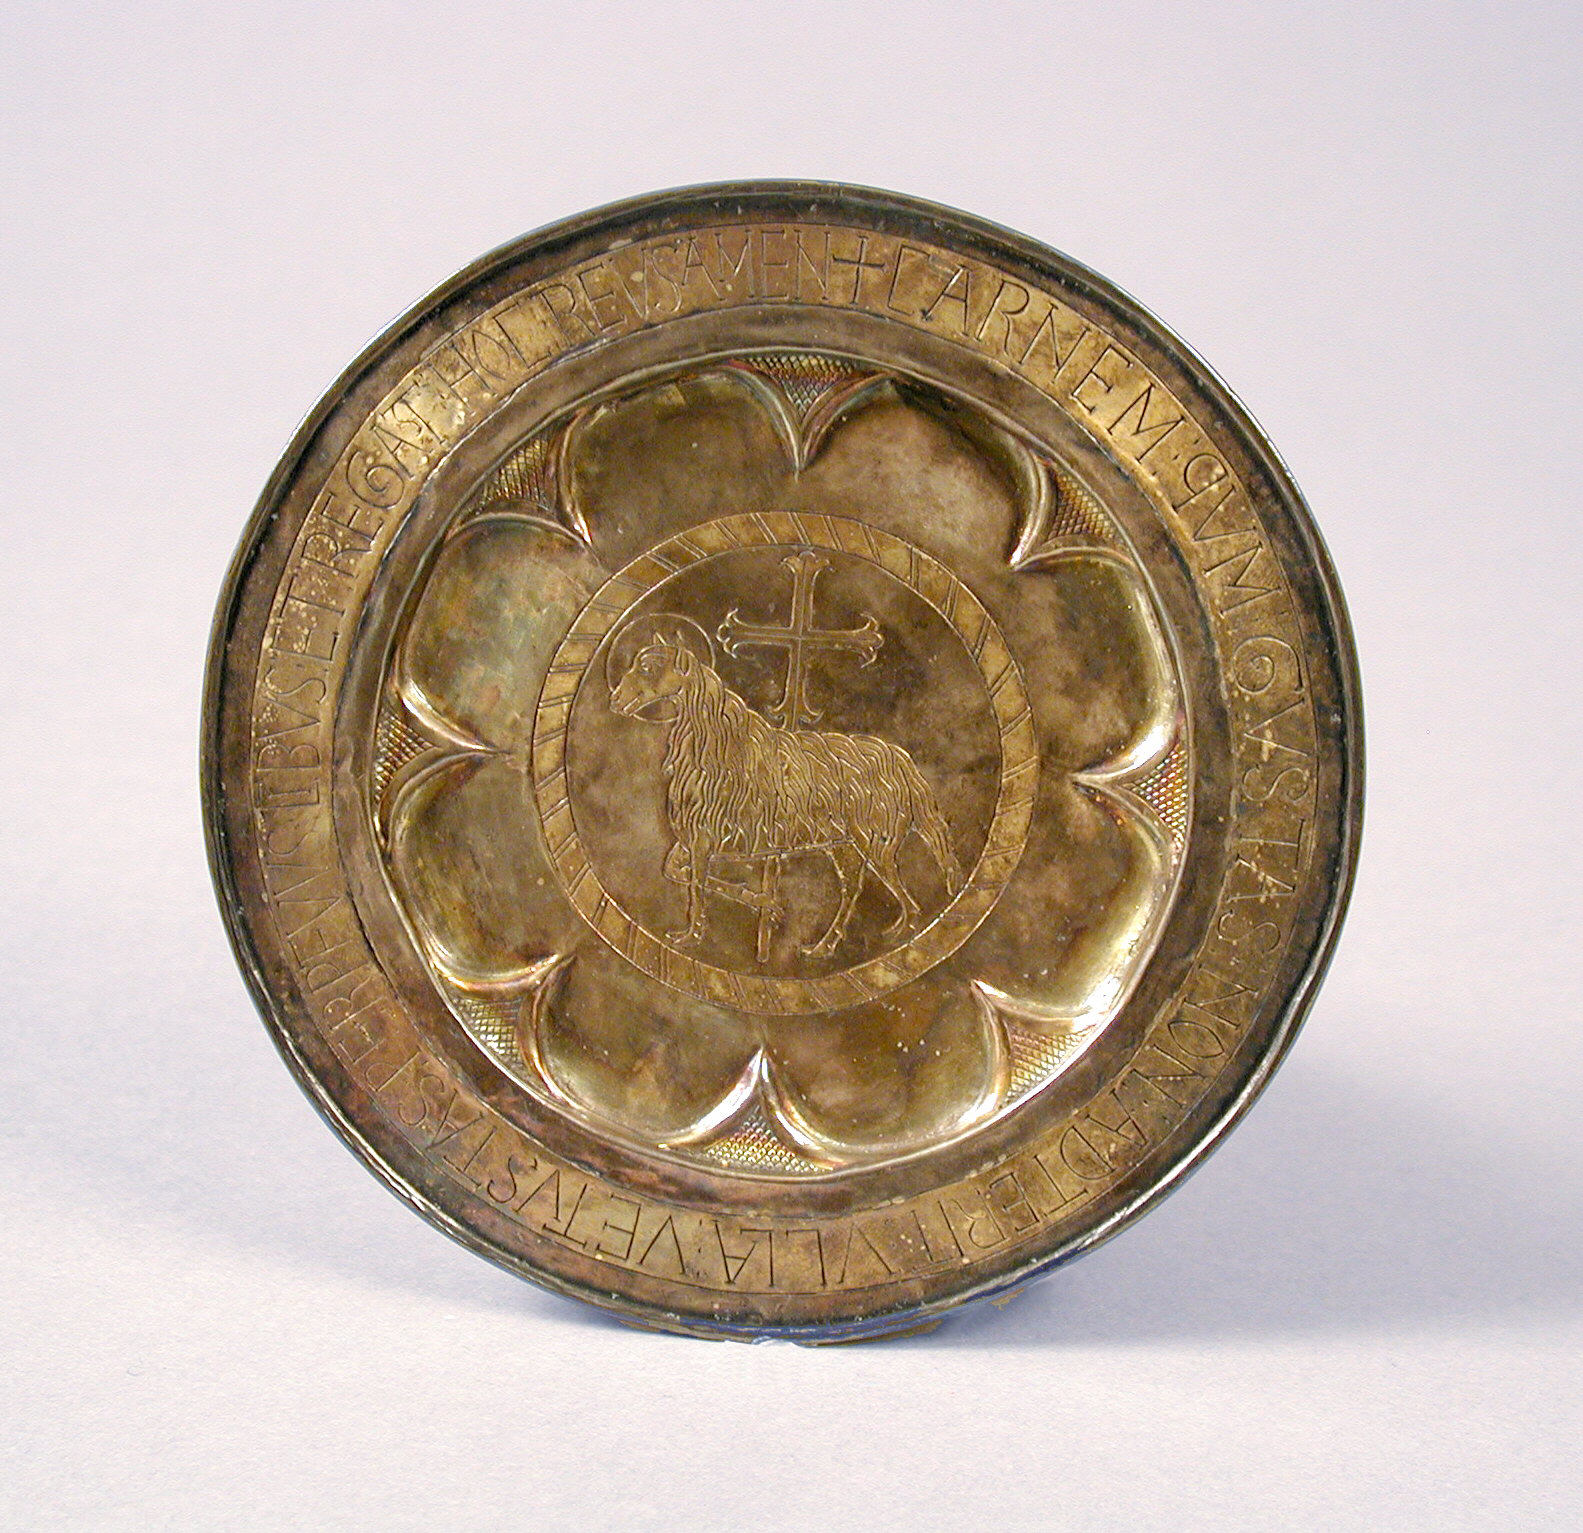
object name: paten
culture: spanish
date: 1901-1933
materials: silver gilt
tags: animals,cross